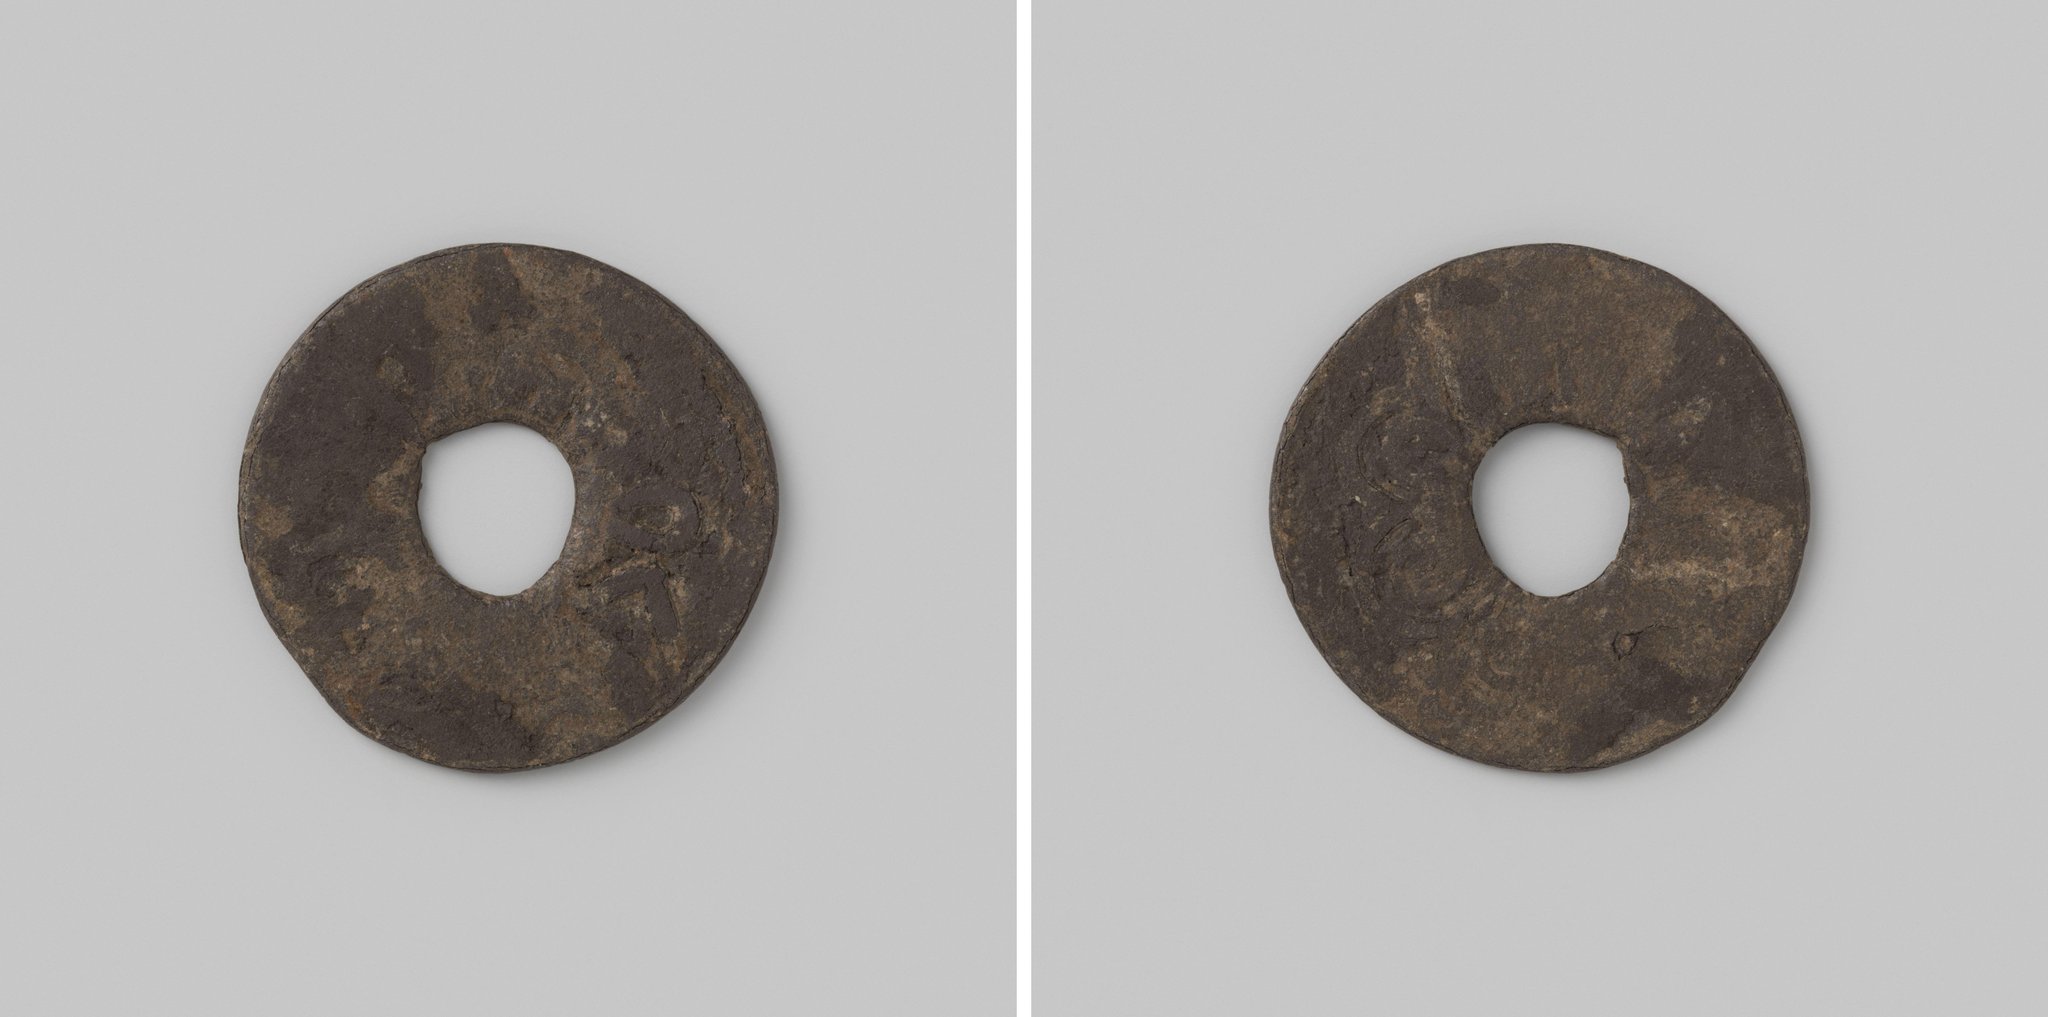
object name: coin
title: Pitji van het Sultanaat Kedah, deel van Thailand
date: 1821-1900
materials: tin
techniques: casting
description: Tinnen munt. Voorzijde: lotusbloem. Keerzijde: niet nader te determineren omschrift in Arabische lettertekens. In het midden zeshoekig gat.